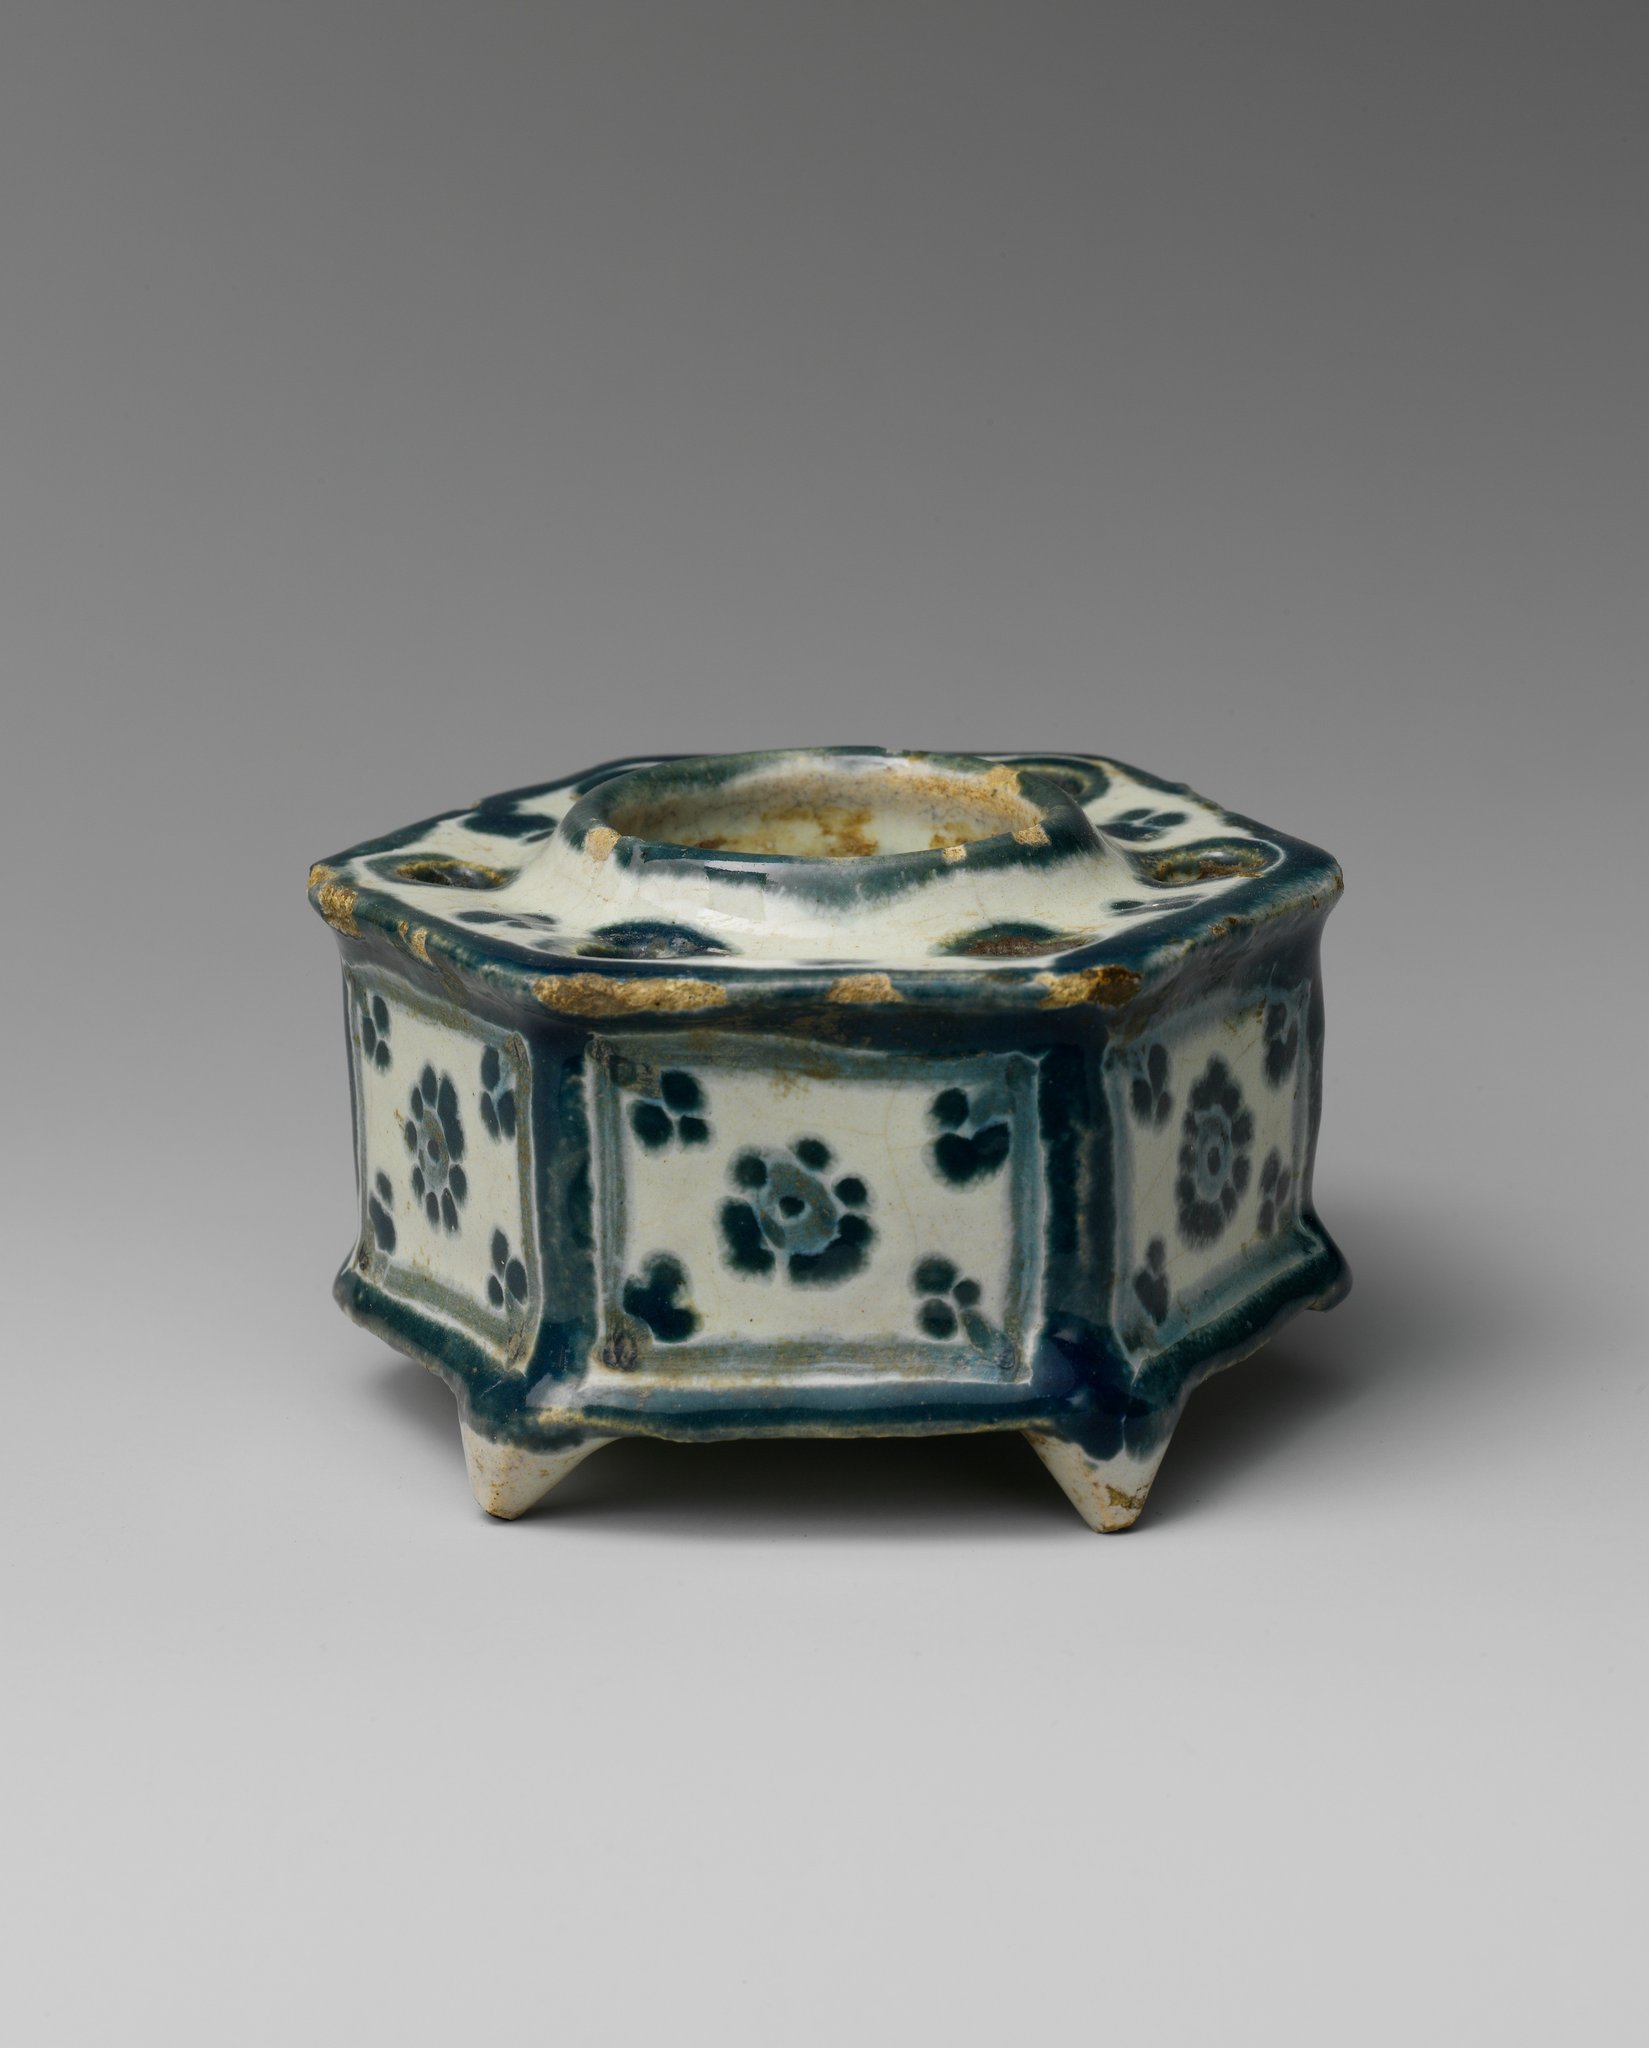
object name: inkwell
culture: mexican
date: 1750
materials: earthenware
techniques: glazing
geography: mexico